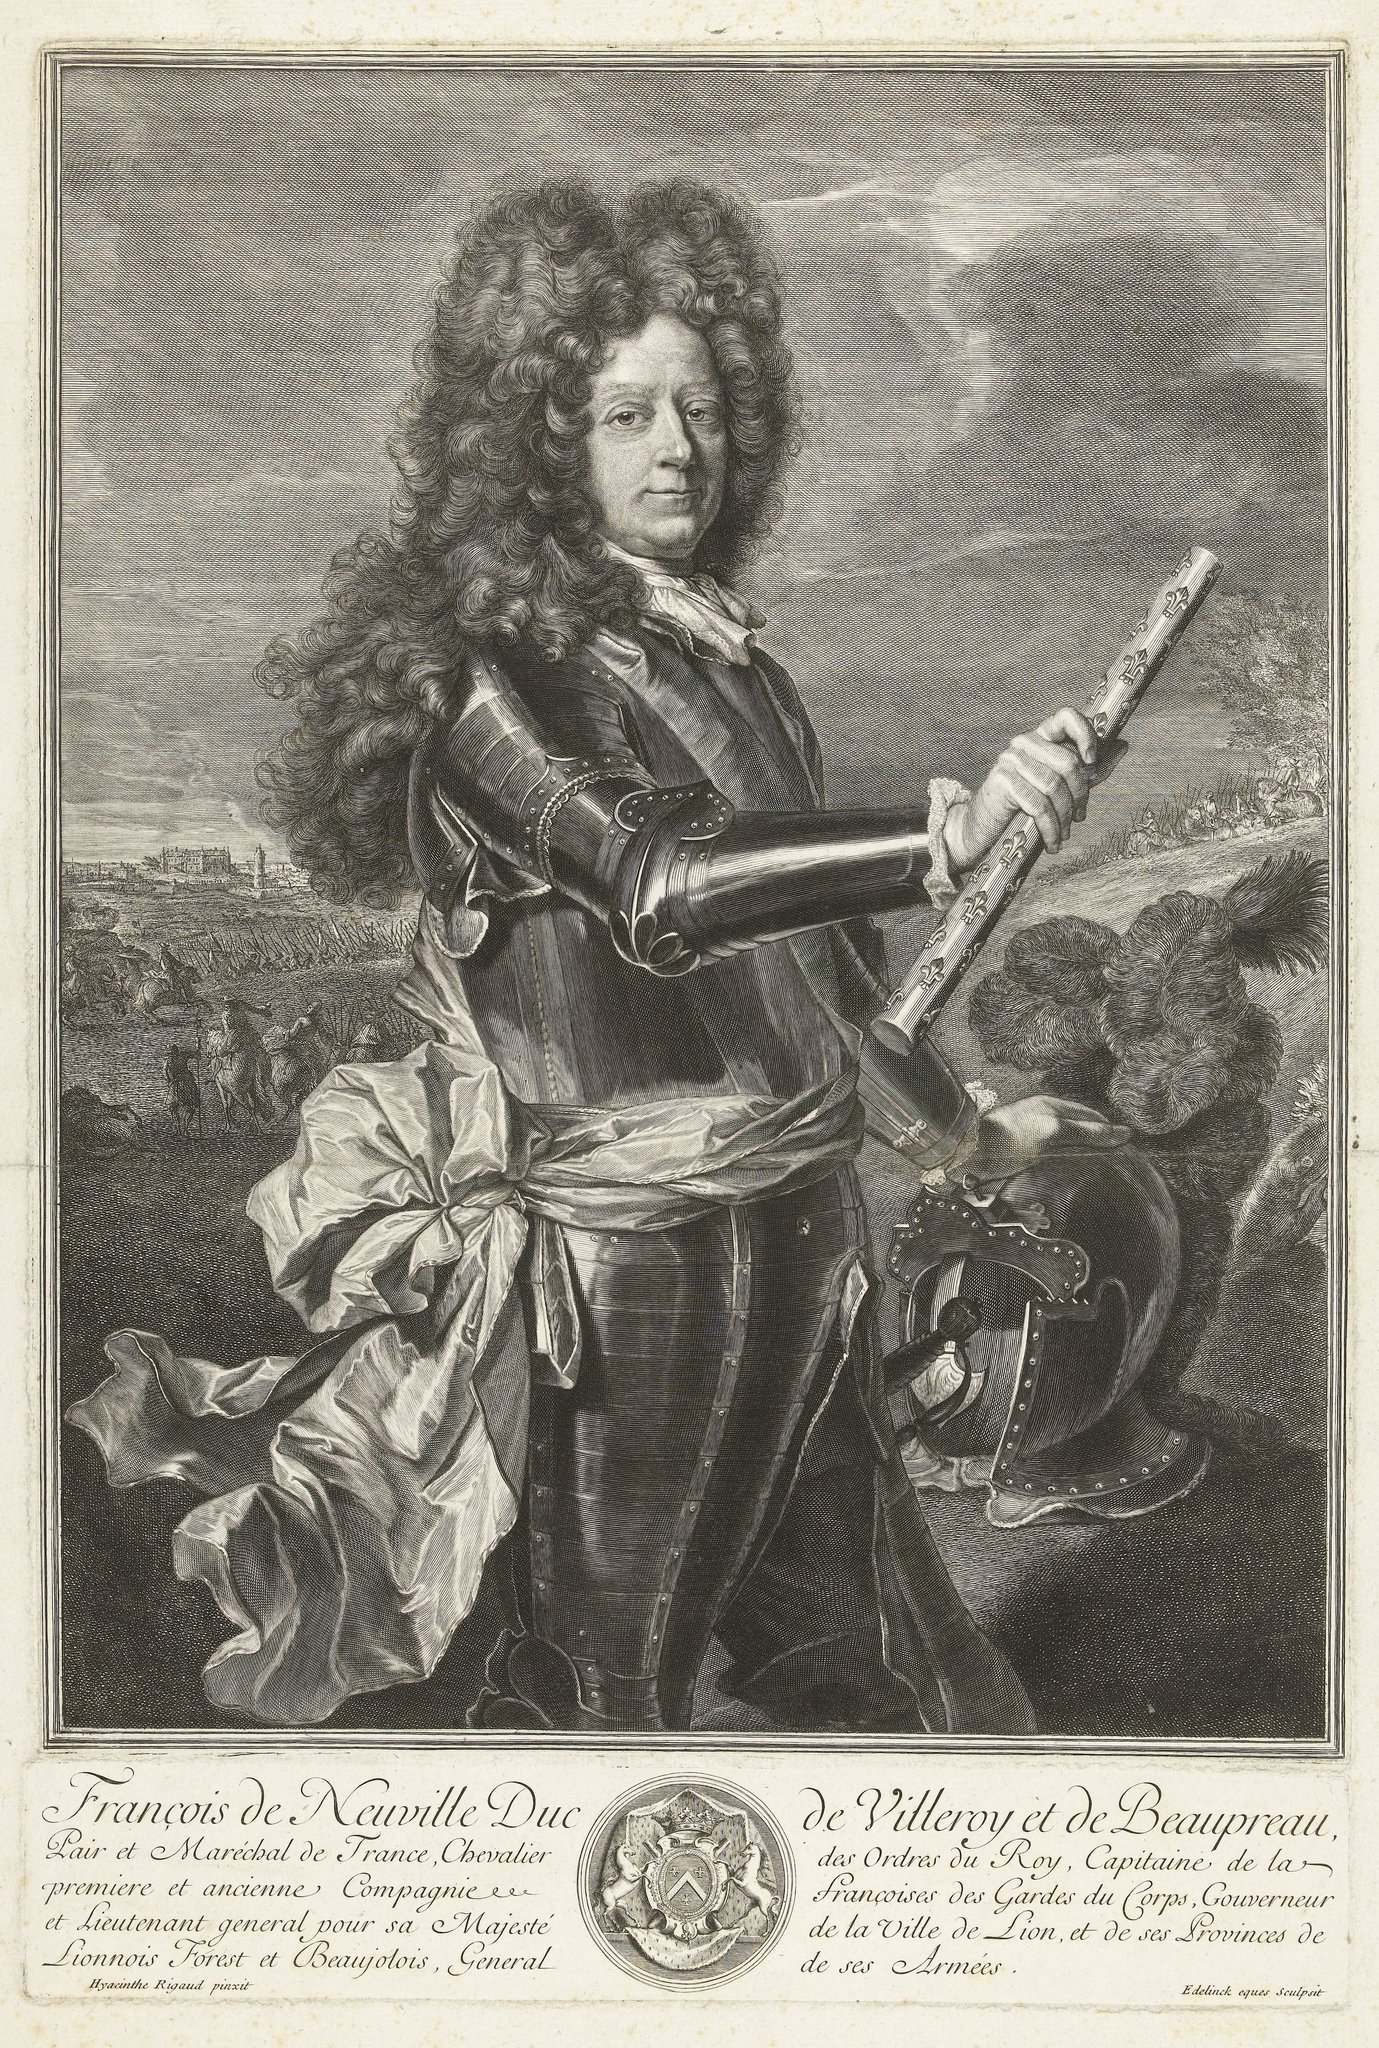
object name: print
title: Portret van François de Neufville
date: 1669-1702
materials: paper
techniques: engraving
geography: france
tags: lyon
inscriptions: collector's mark: Lugt 240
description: François de Neufville (1644-1730), hertog van Villeroy, maarschalk van Frankrijk. Ten halven lijve afgebeeld in harnas met helm in de ene hand en zijn commandostaf in de andere. Op de achtergrond een slagveld. Onder het portret een Franse tekst van vijf regels met in het midden een wapen.